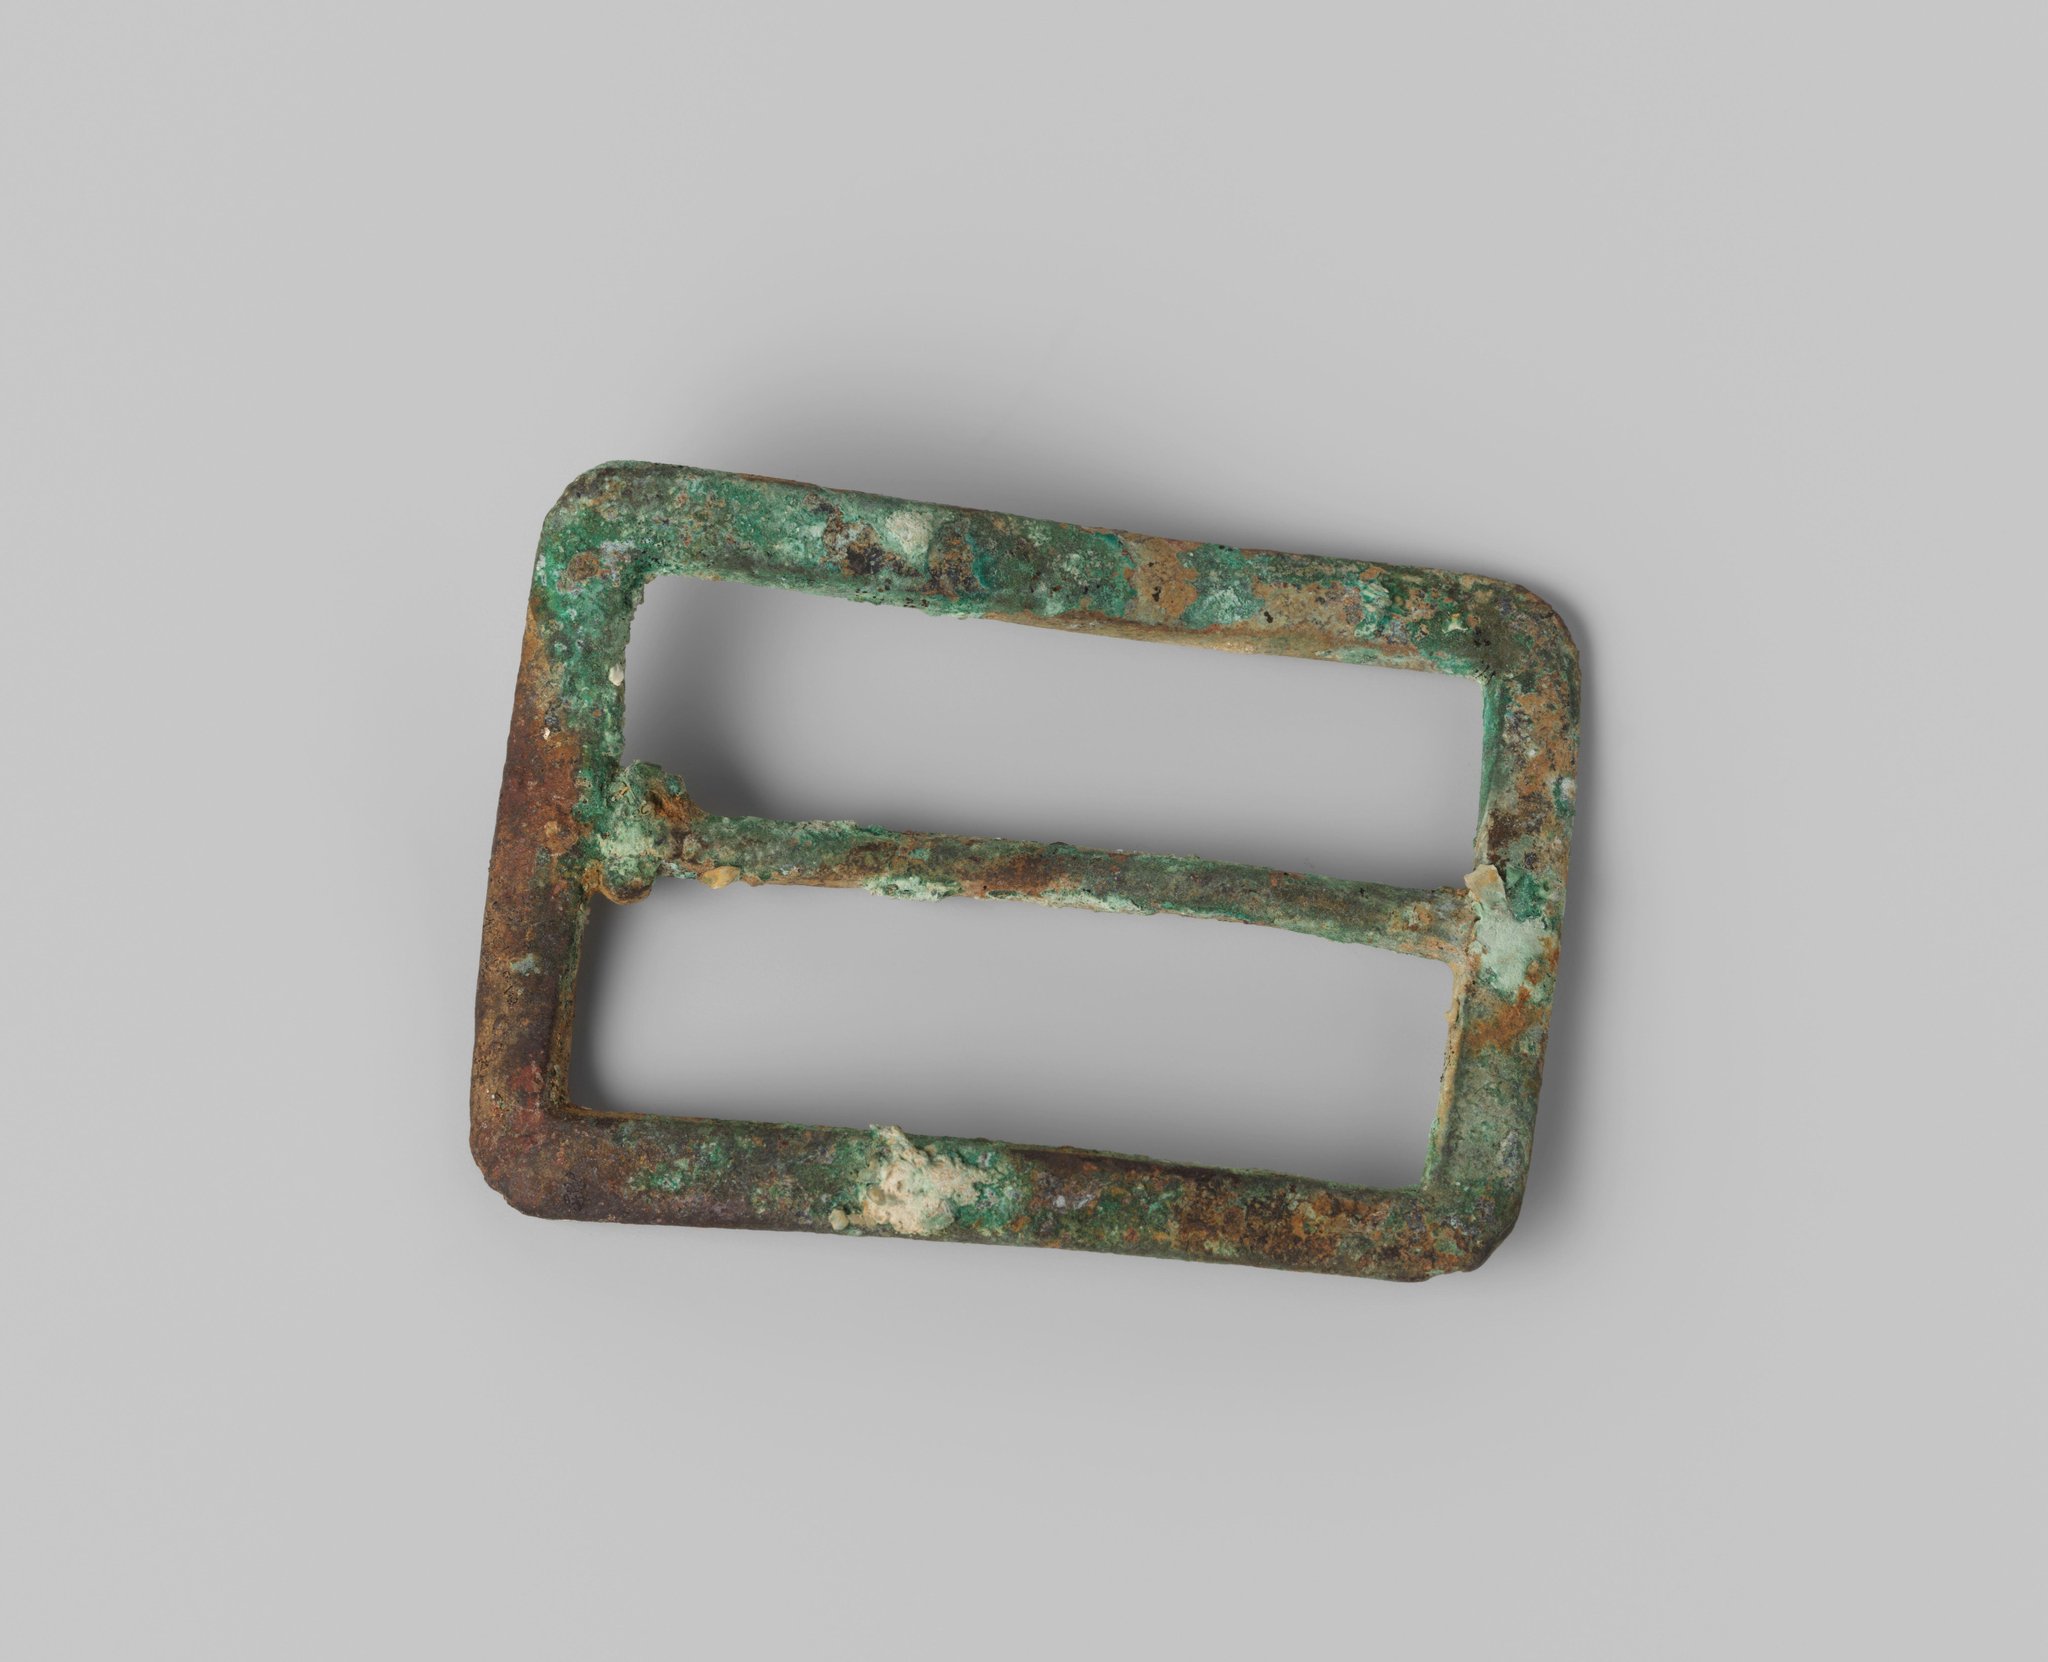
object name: belt buckle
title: Riemgesp uit het wrak van de Oost-Indiëvaarder Hollandia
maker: Anonymous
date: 1700-1743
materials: copper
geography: netherlands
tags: verenigde oostindische compagnie, hollandia (schip), annet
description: Rectangular, ring with spindle, id. NG 1980-27H2796, belt buckle.